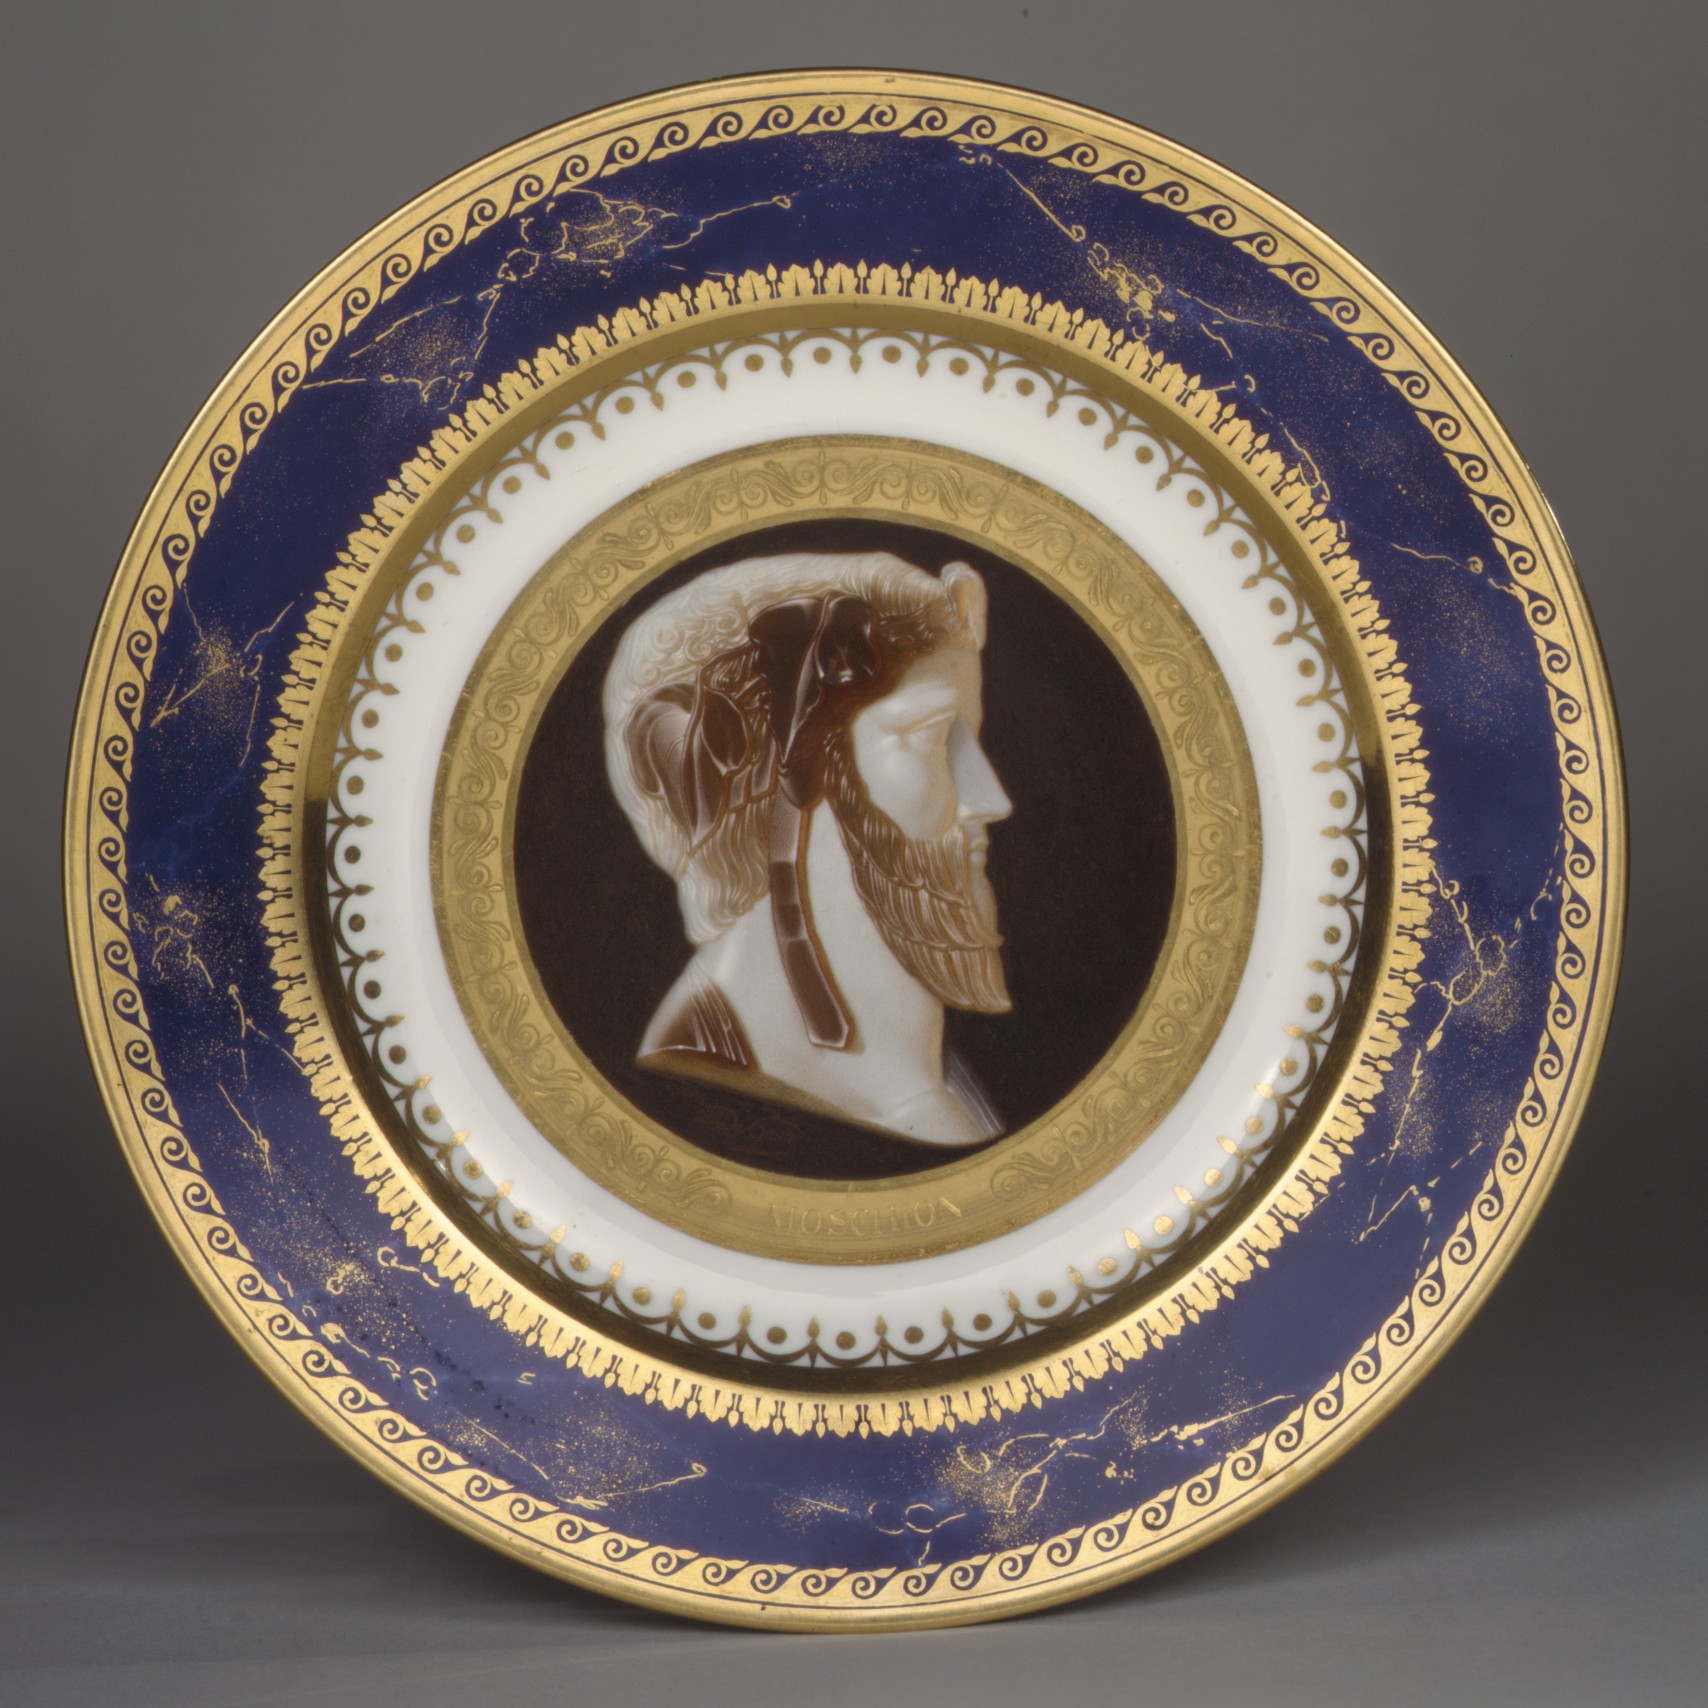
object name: plate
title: Plate with imaginary portrait of the tragic poet Moschion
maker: sèvres manufactory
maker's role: manufactory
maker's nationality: french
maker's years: 1740-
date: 1811-1818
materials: hard paste porcelain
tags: men,profiles